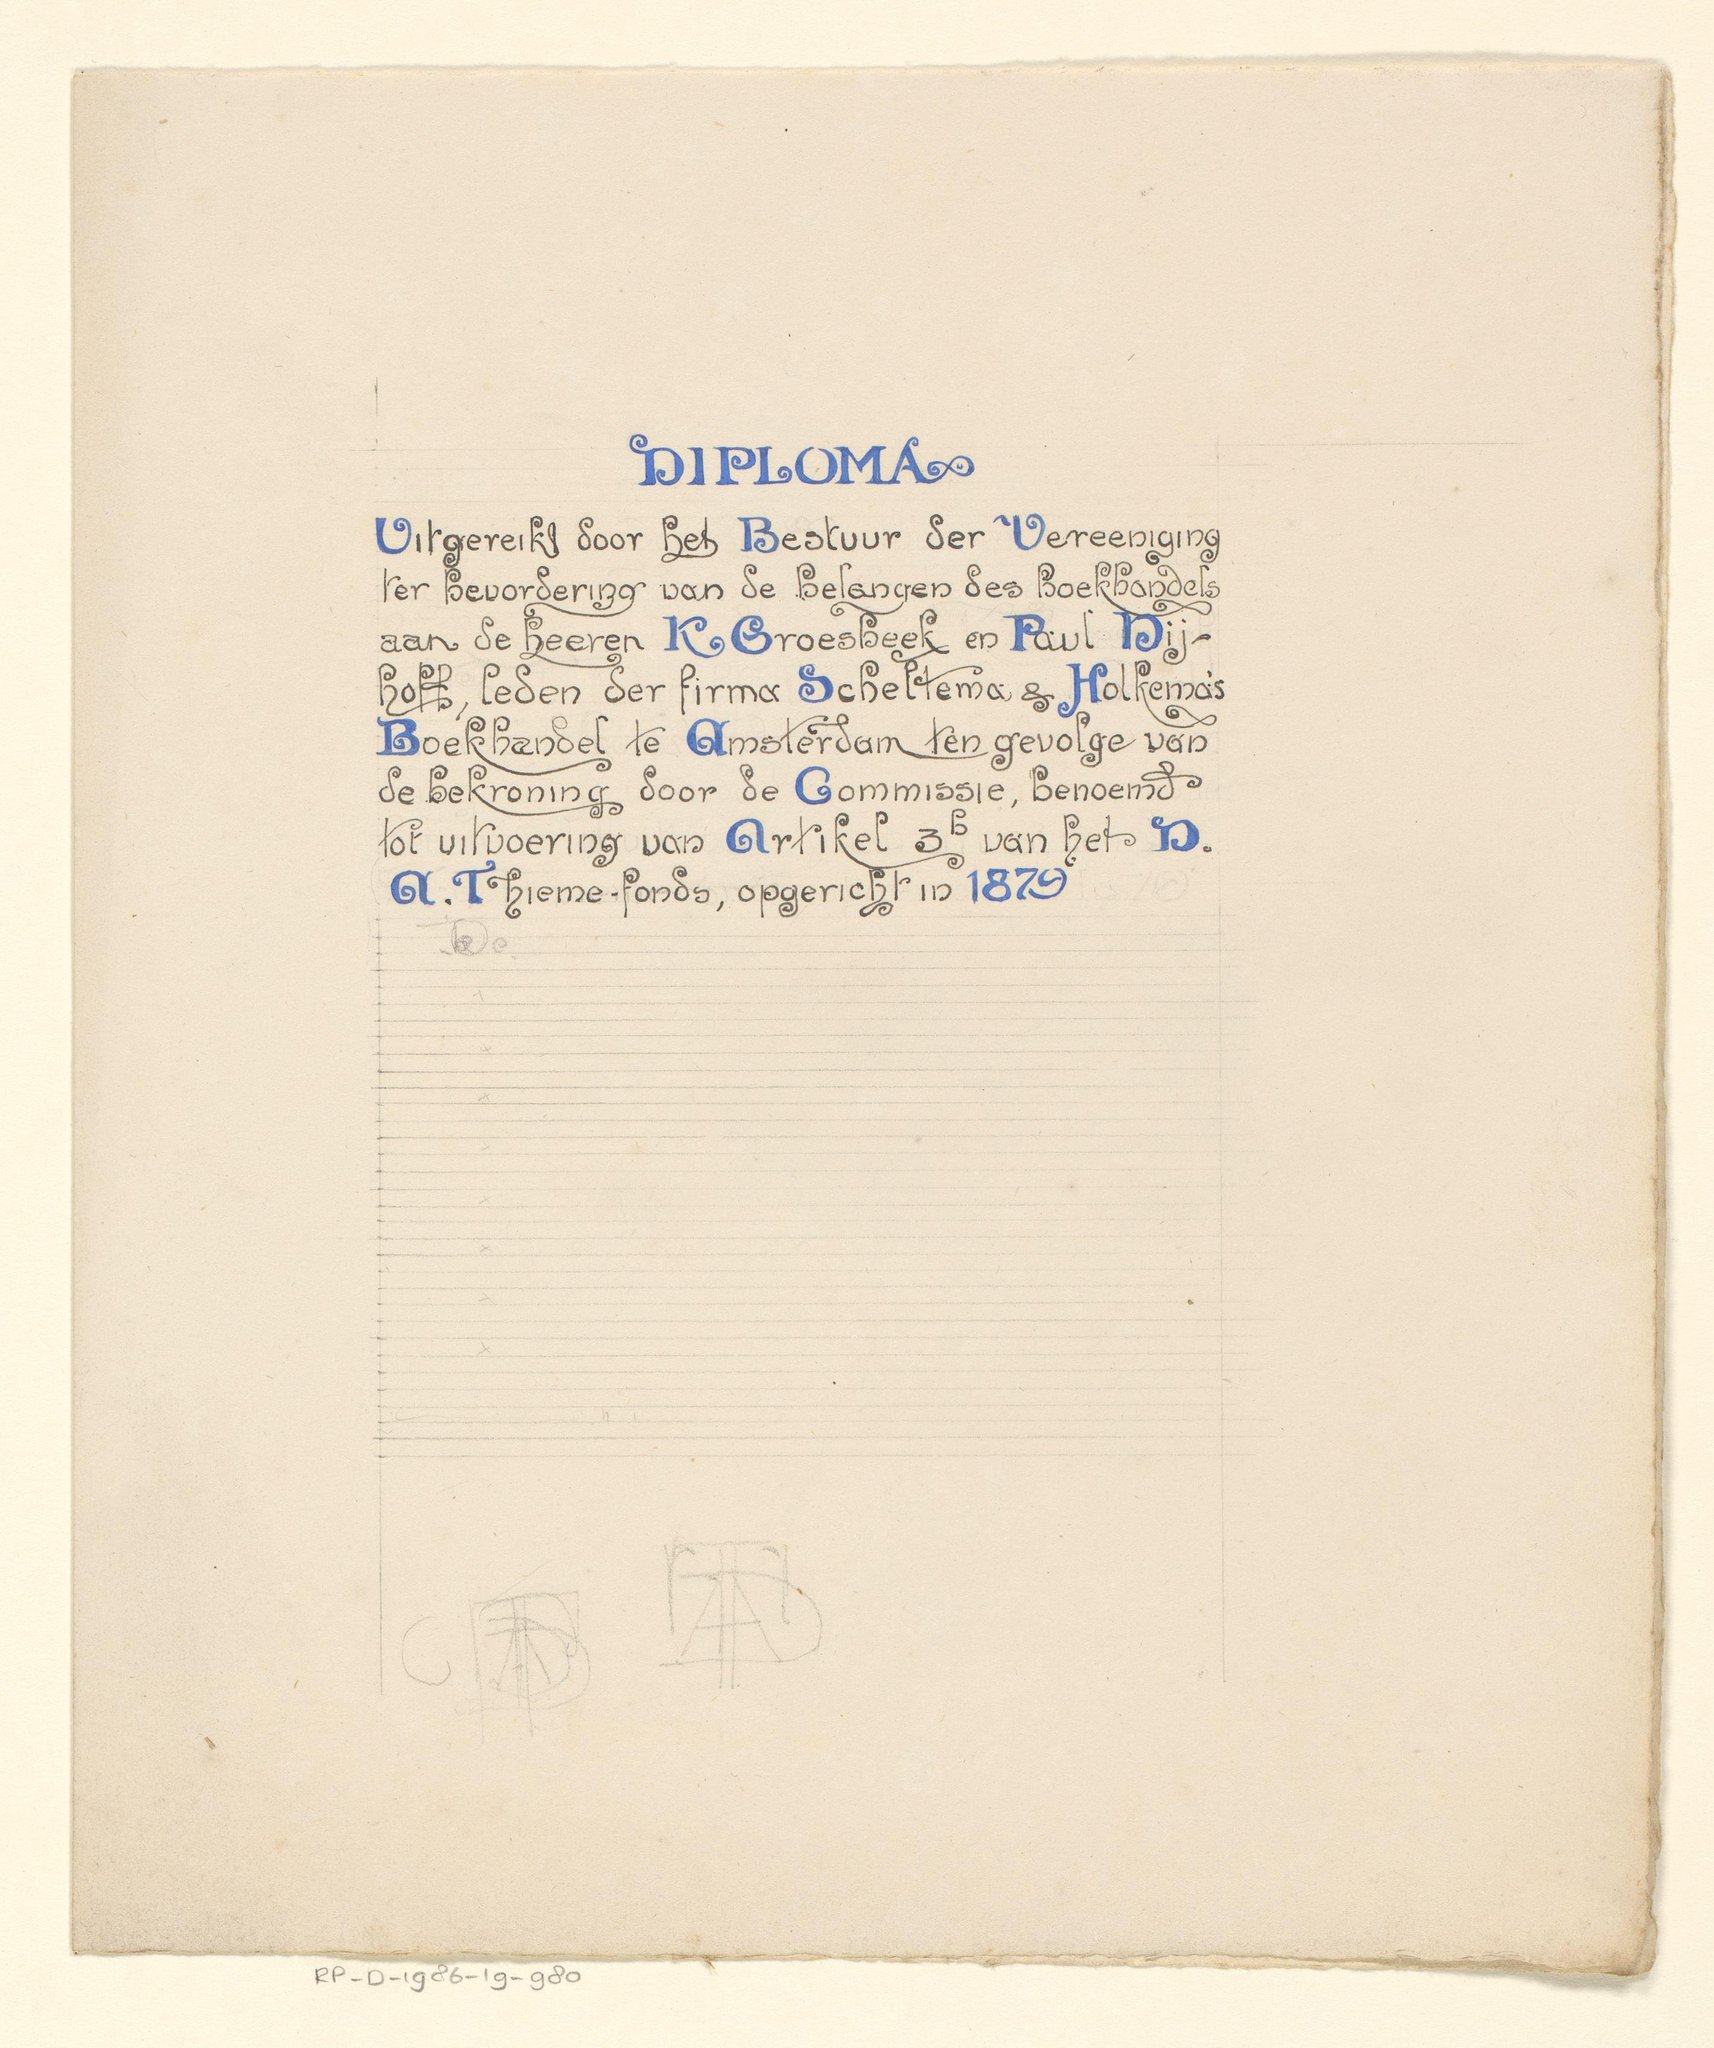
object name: design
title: Ontwerp voor een diploma van de Vereniging ter Bevordering van de Belangen des Boekhandels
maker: reinier willem petrus de vries (1874-1953)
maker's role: draughtsman, print maker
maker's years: 1874-1953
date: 1909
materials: paint, ink, paper, pencil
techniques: brush, pen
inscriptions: collector's mark: ‘R:MVS.’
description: Het diploma is bedoeld voor K. Groesbeek en P. Dijhoff.